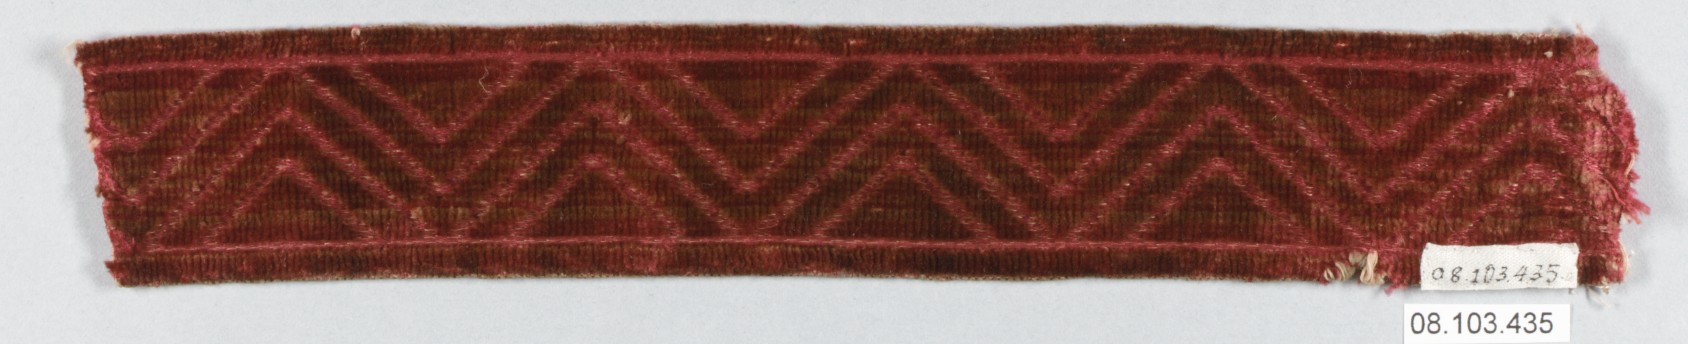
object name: galloon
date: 1701-1900